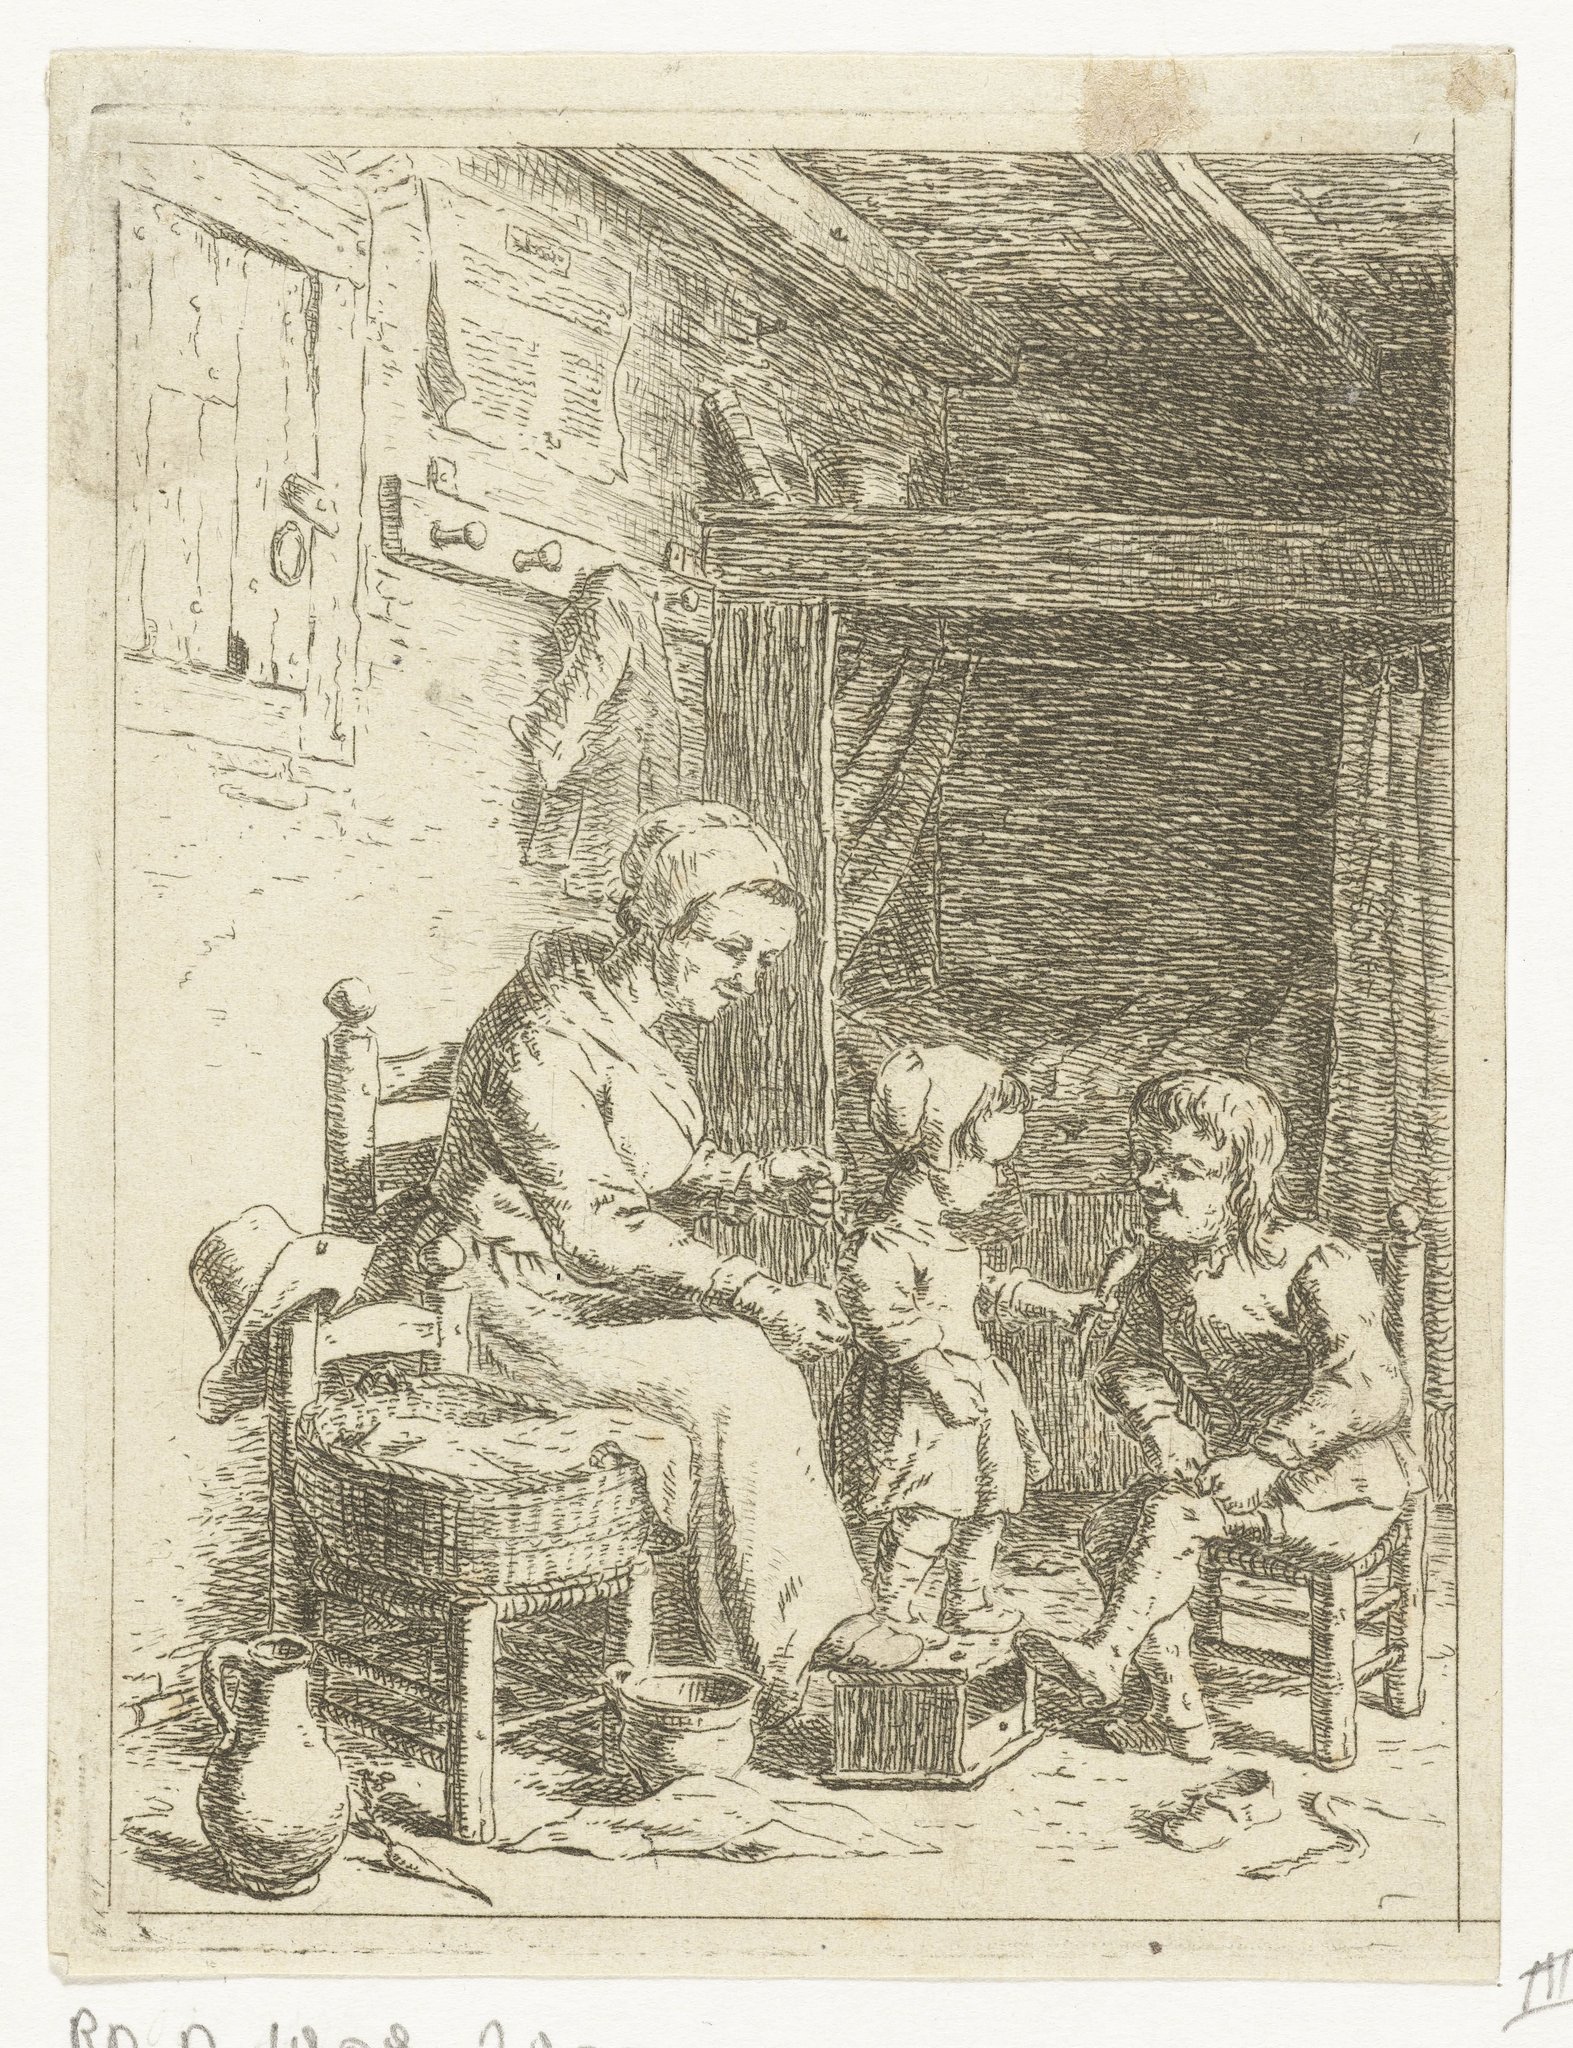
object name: print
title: Ochtentoilet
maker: christina chalon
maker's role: draughtsman, print maker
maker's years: 1748-1808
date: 1758-1808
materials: paper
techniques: etching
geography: leiden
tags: dressing oneself, getting dressed, mother and child(ren), woman and child(ren) (family group) (with number of children), dressing oneself, getting dressed - aa - female human figure, bedroom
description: Interieur van een slaapkamer. Een moeder helpt haar kinderen bij het ochtendtoilet. Ze vetert het jurkje van haar dochter. Haar zoontje trekt ondertussen zijn kousen aan.